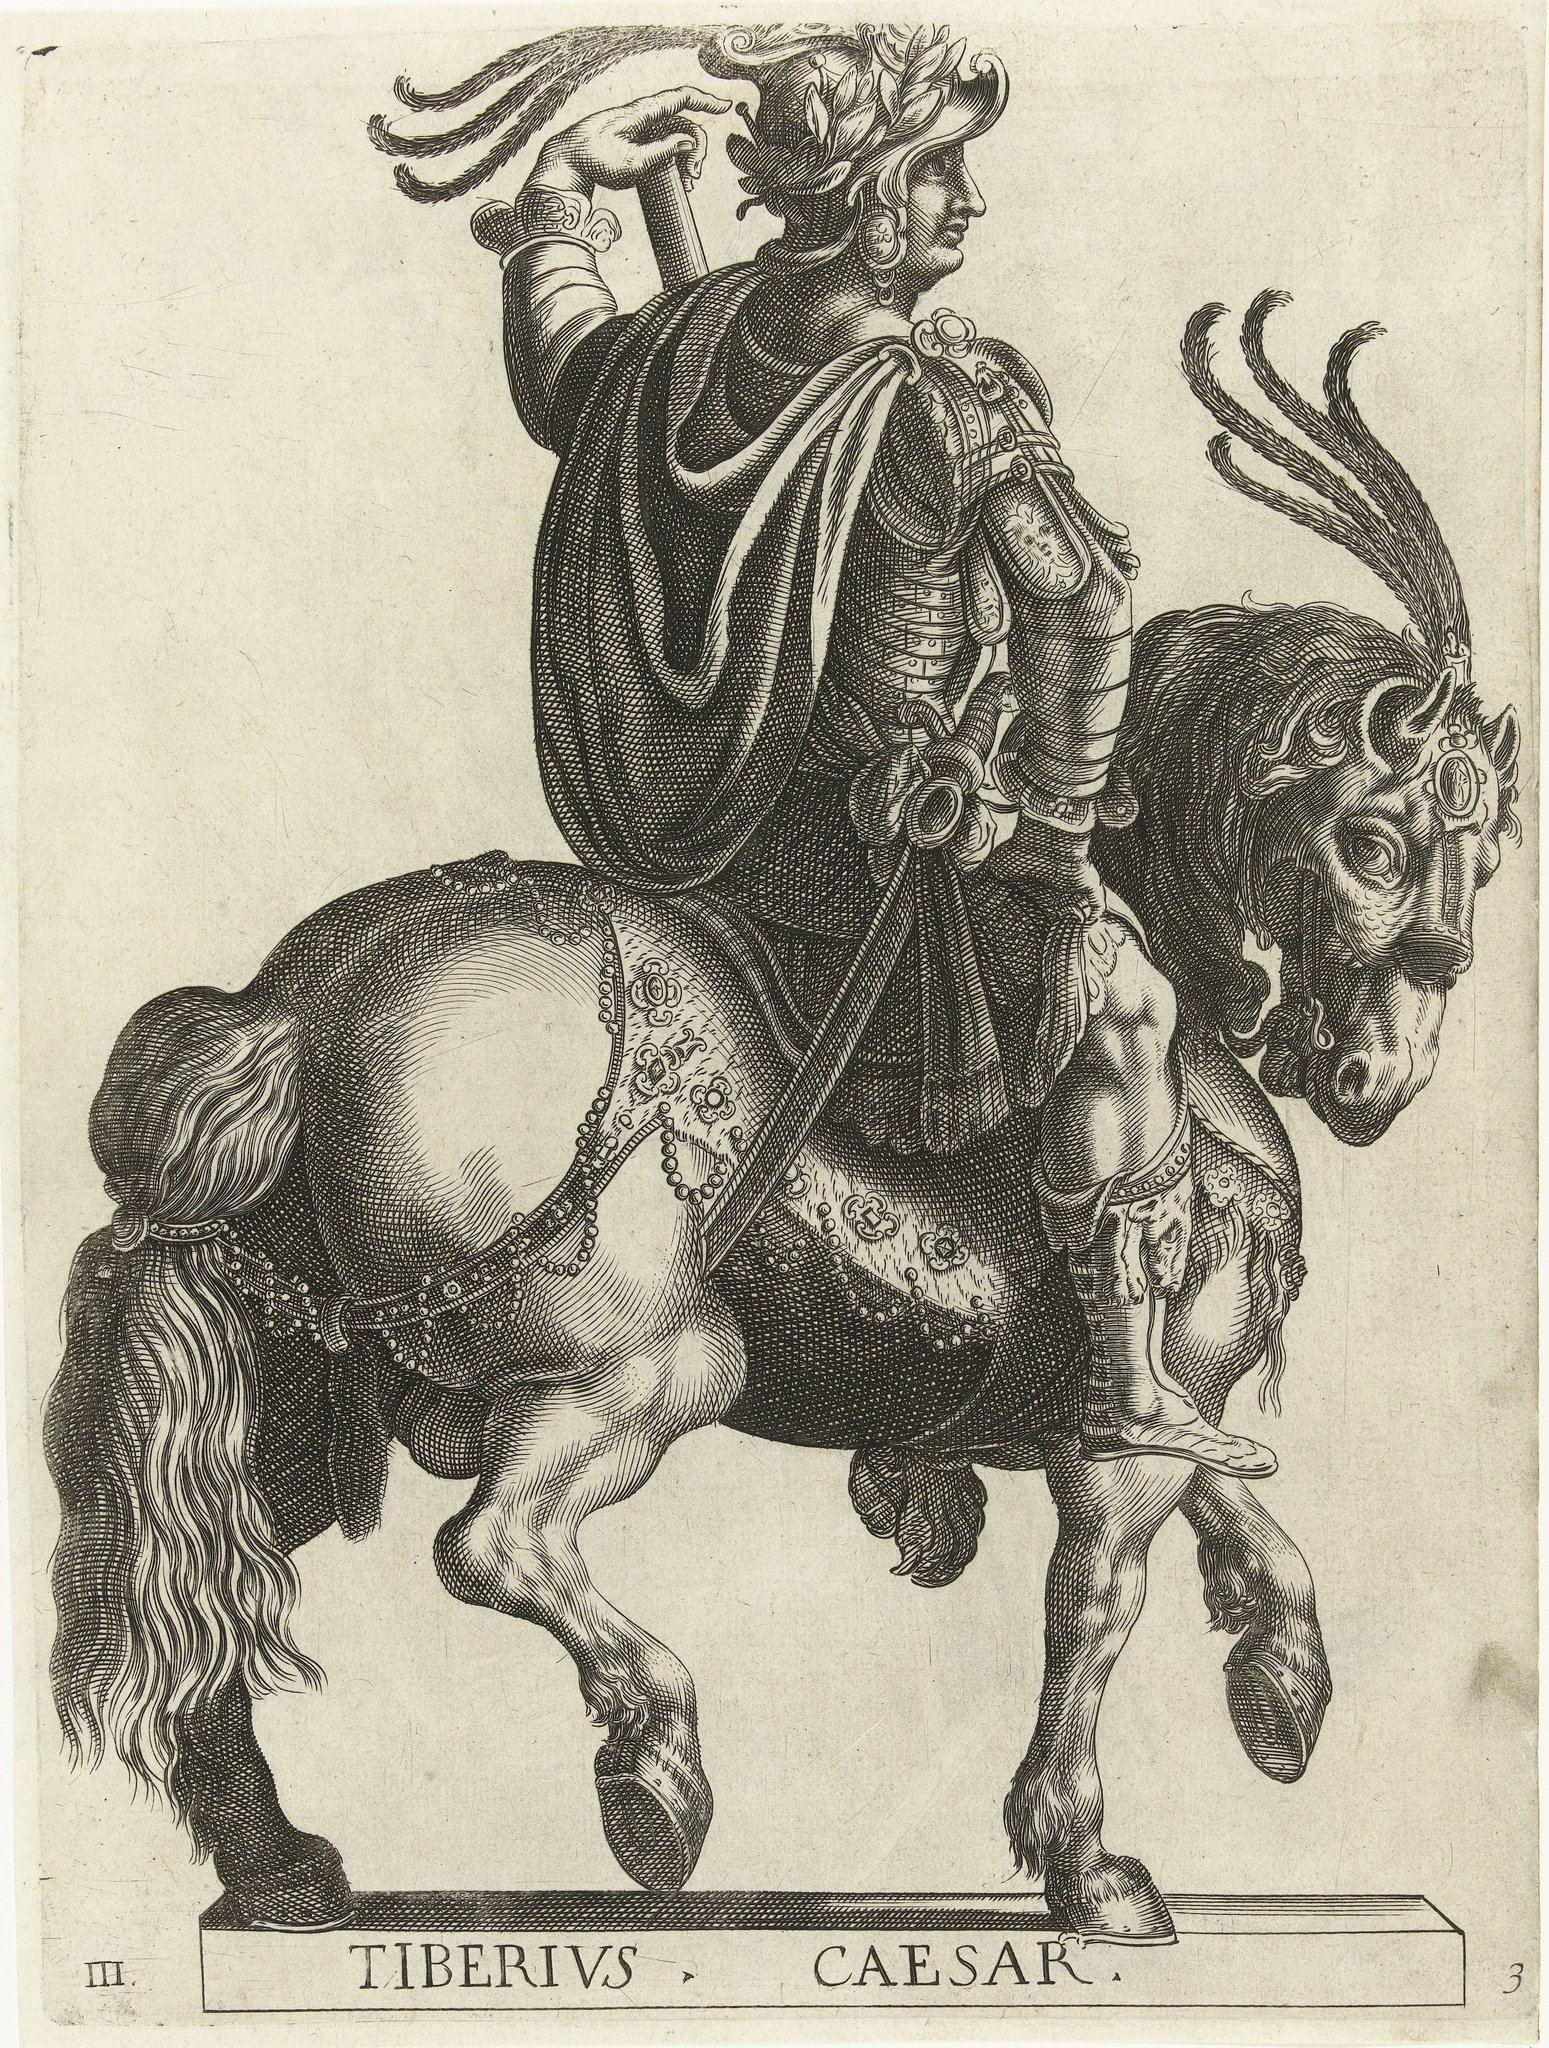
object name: print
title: Portretten van Romeinse keizers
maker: laurens eillarts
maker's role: print maker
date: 1616-1620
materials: paper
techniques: engraving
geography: italy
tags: miseno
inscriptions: collector's mark: Lugt 2228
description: Keizer Tiberius te paard, en profil afgebeeld met één hand op zijn bovenbeen en in de andere zijn commandostaf.